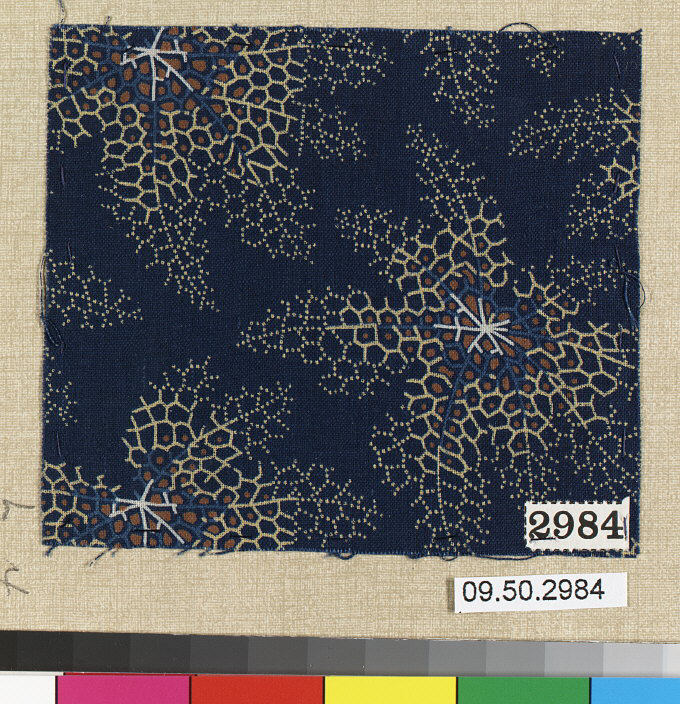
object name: piece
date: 1801-1900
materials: cotton